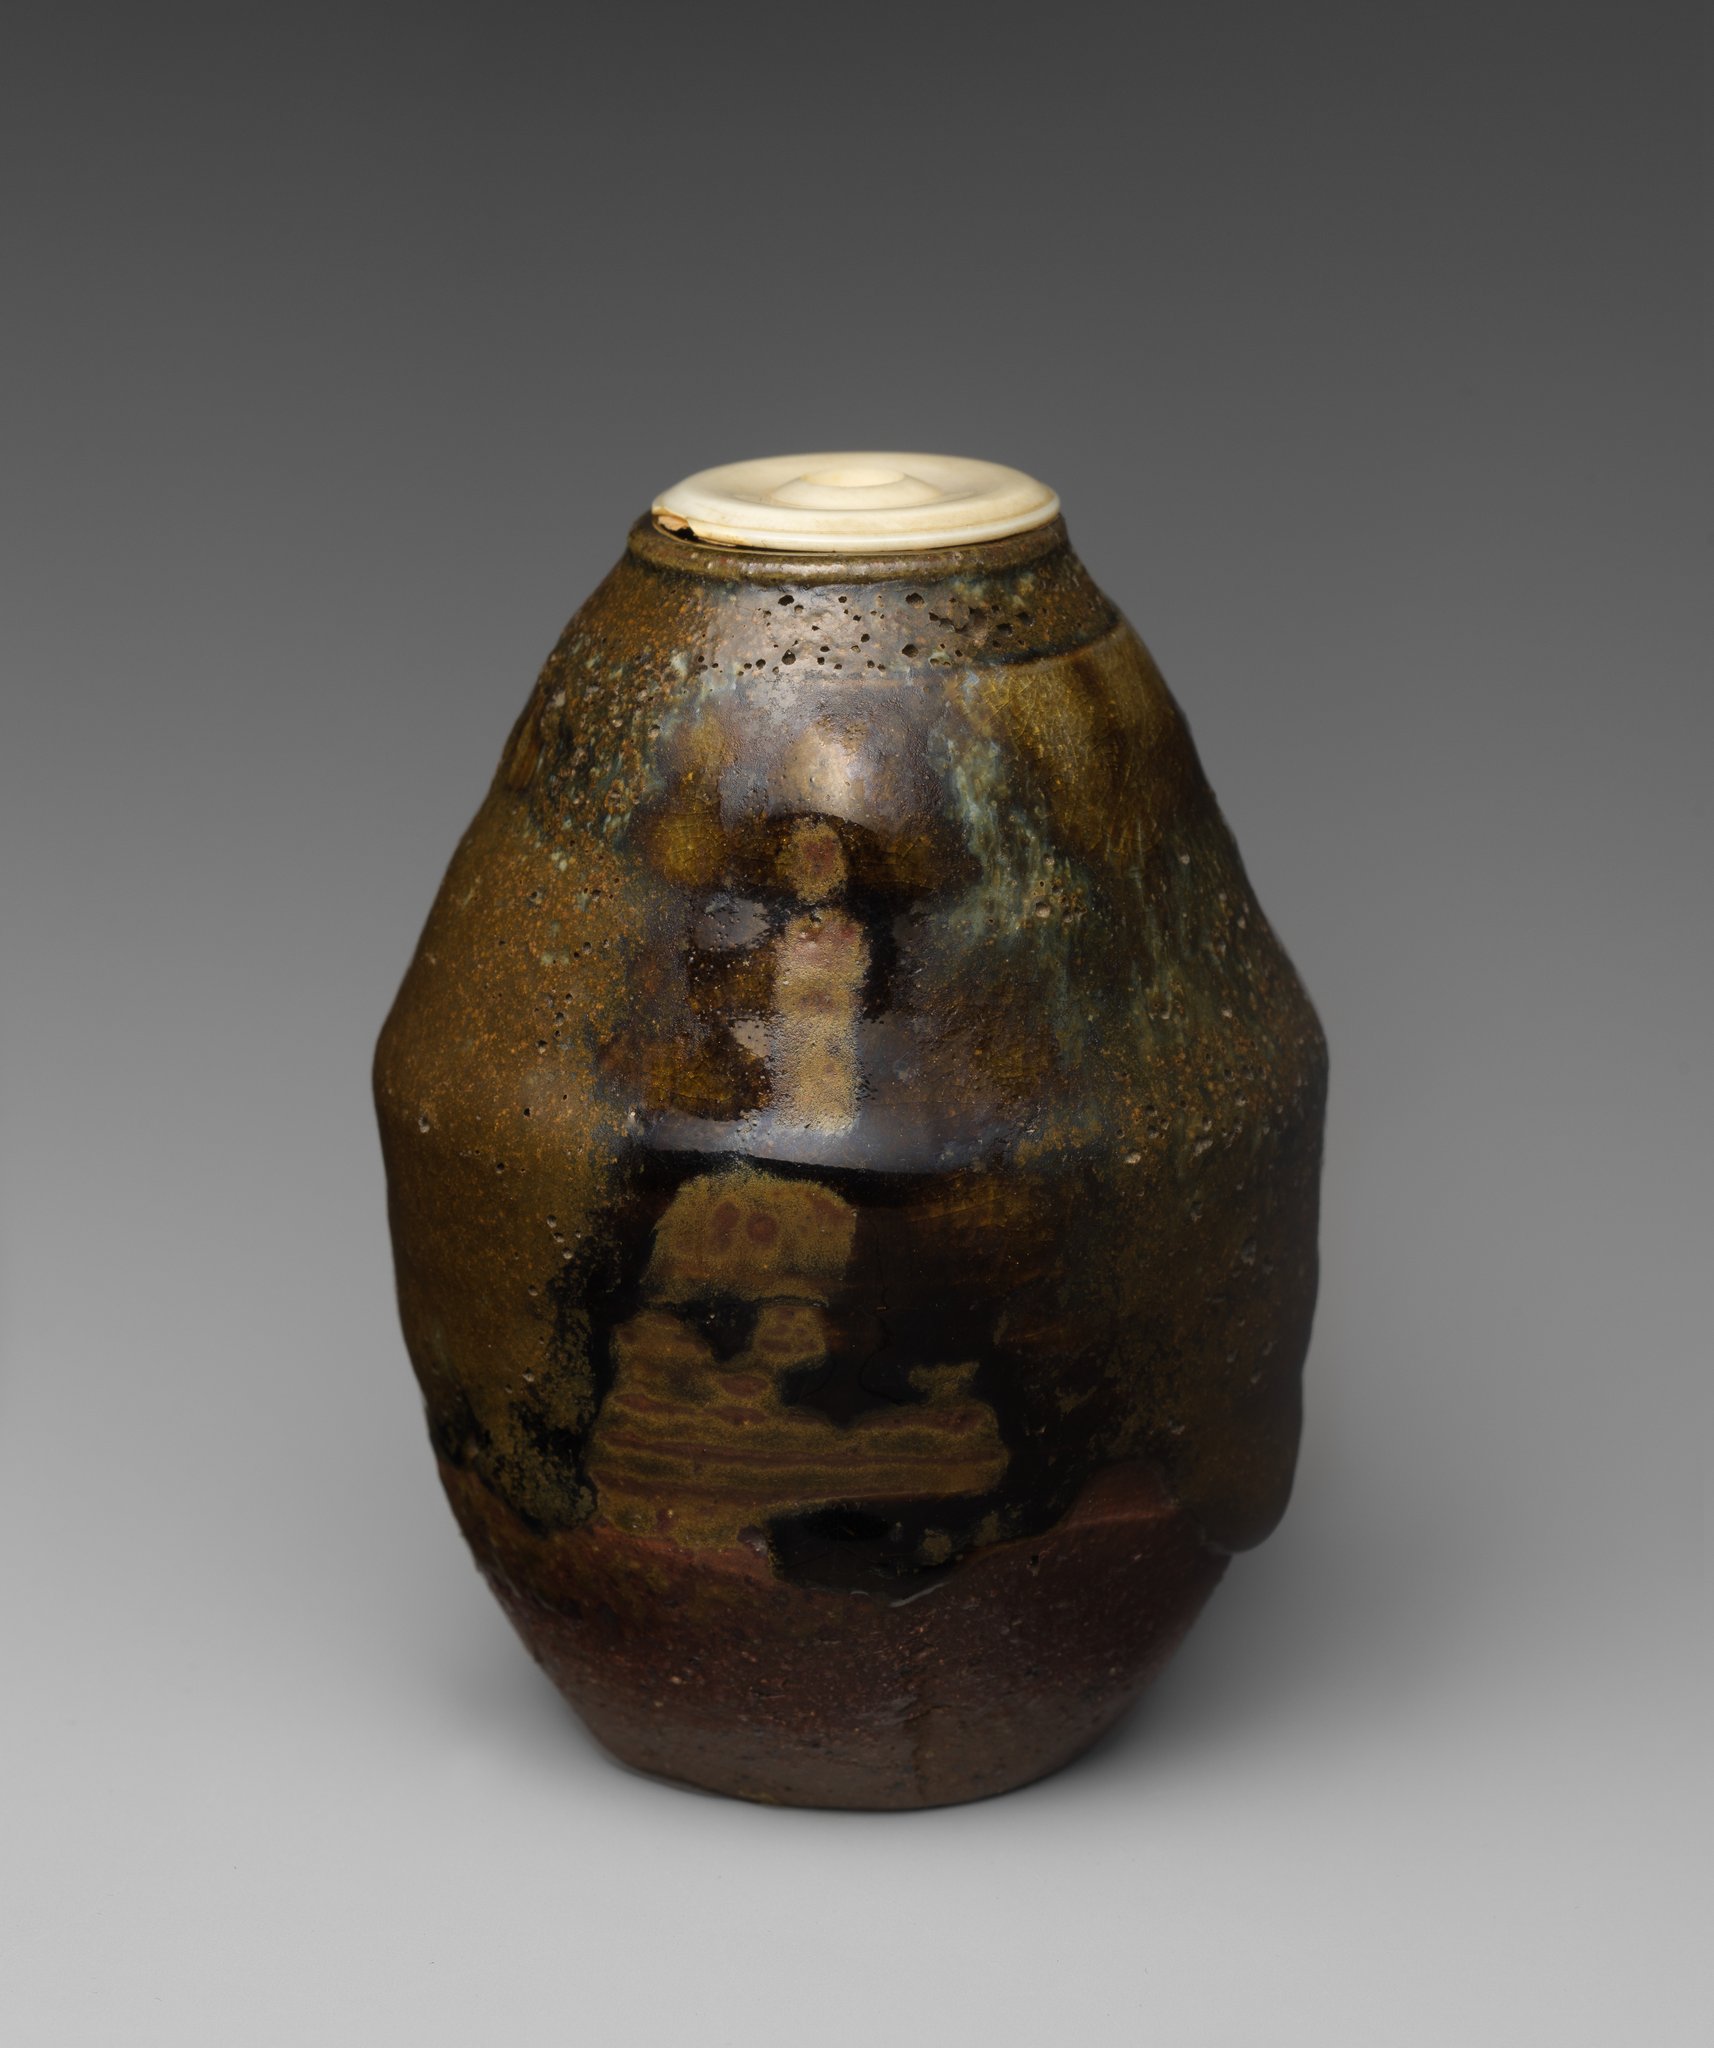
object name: tea jar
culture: japanese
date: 1601-1700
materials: clay, glaze